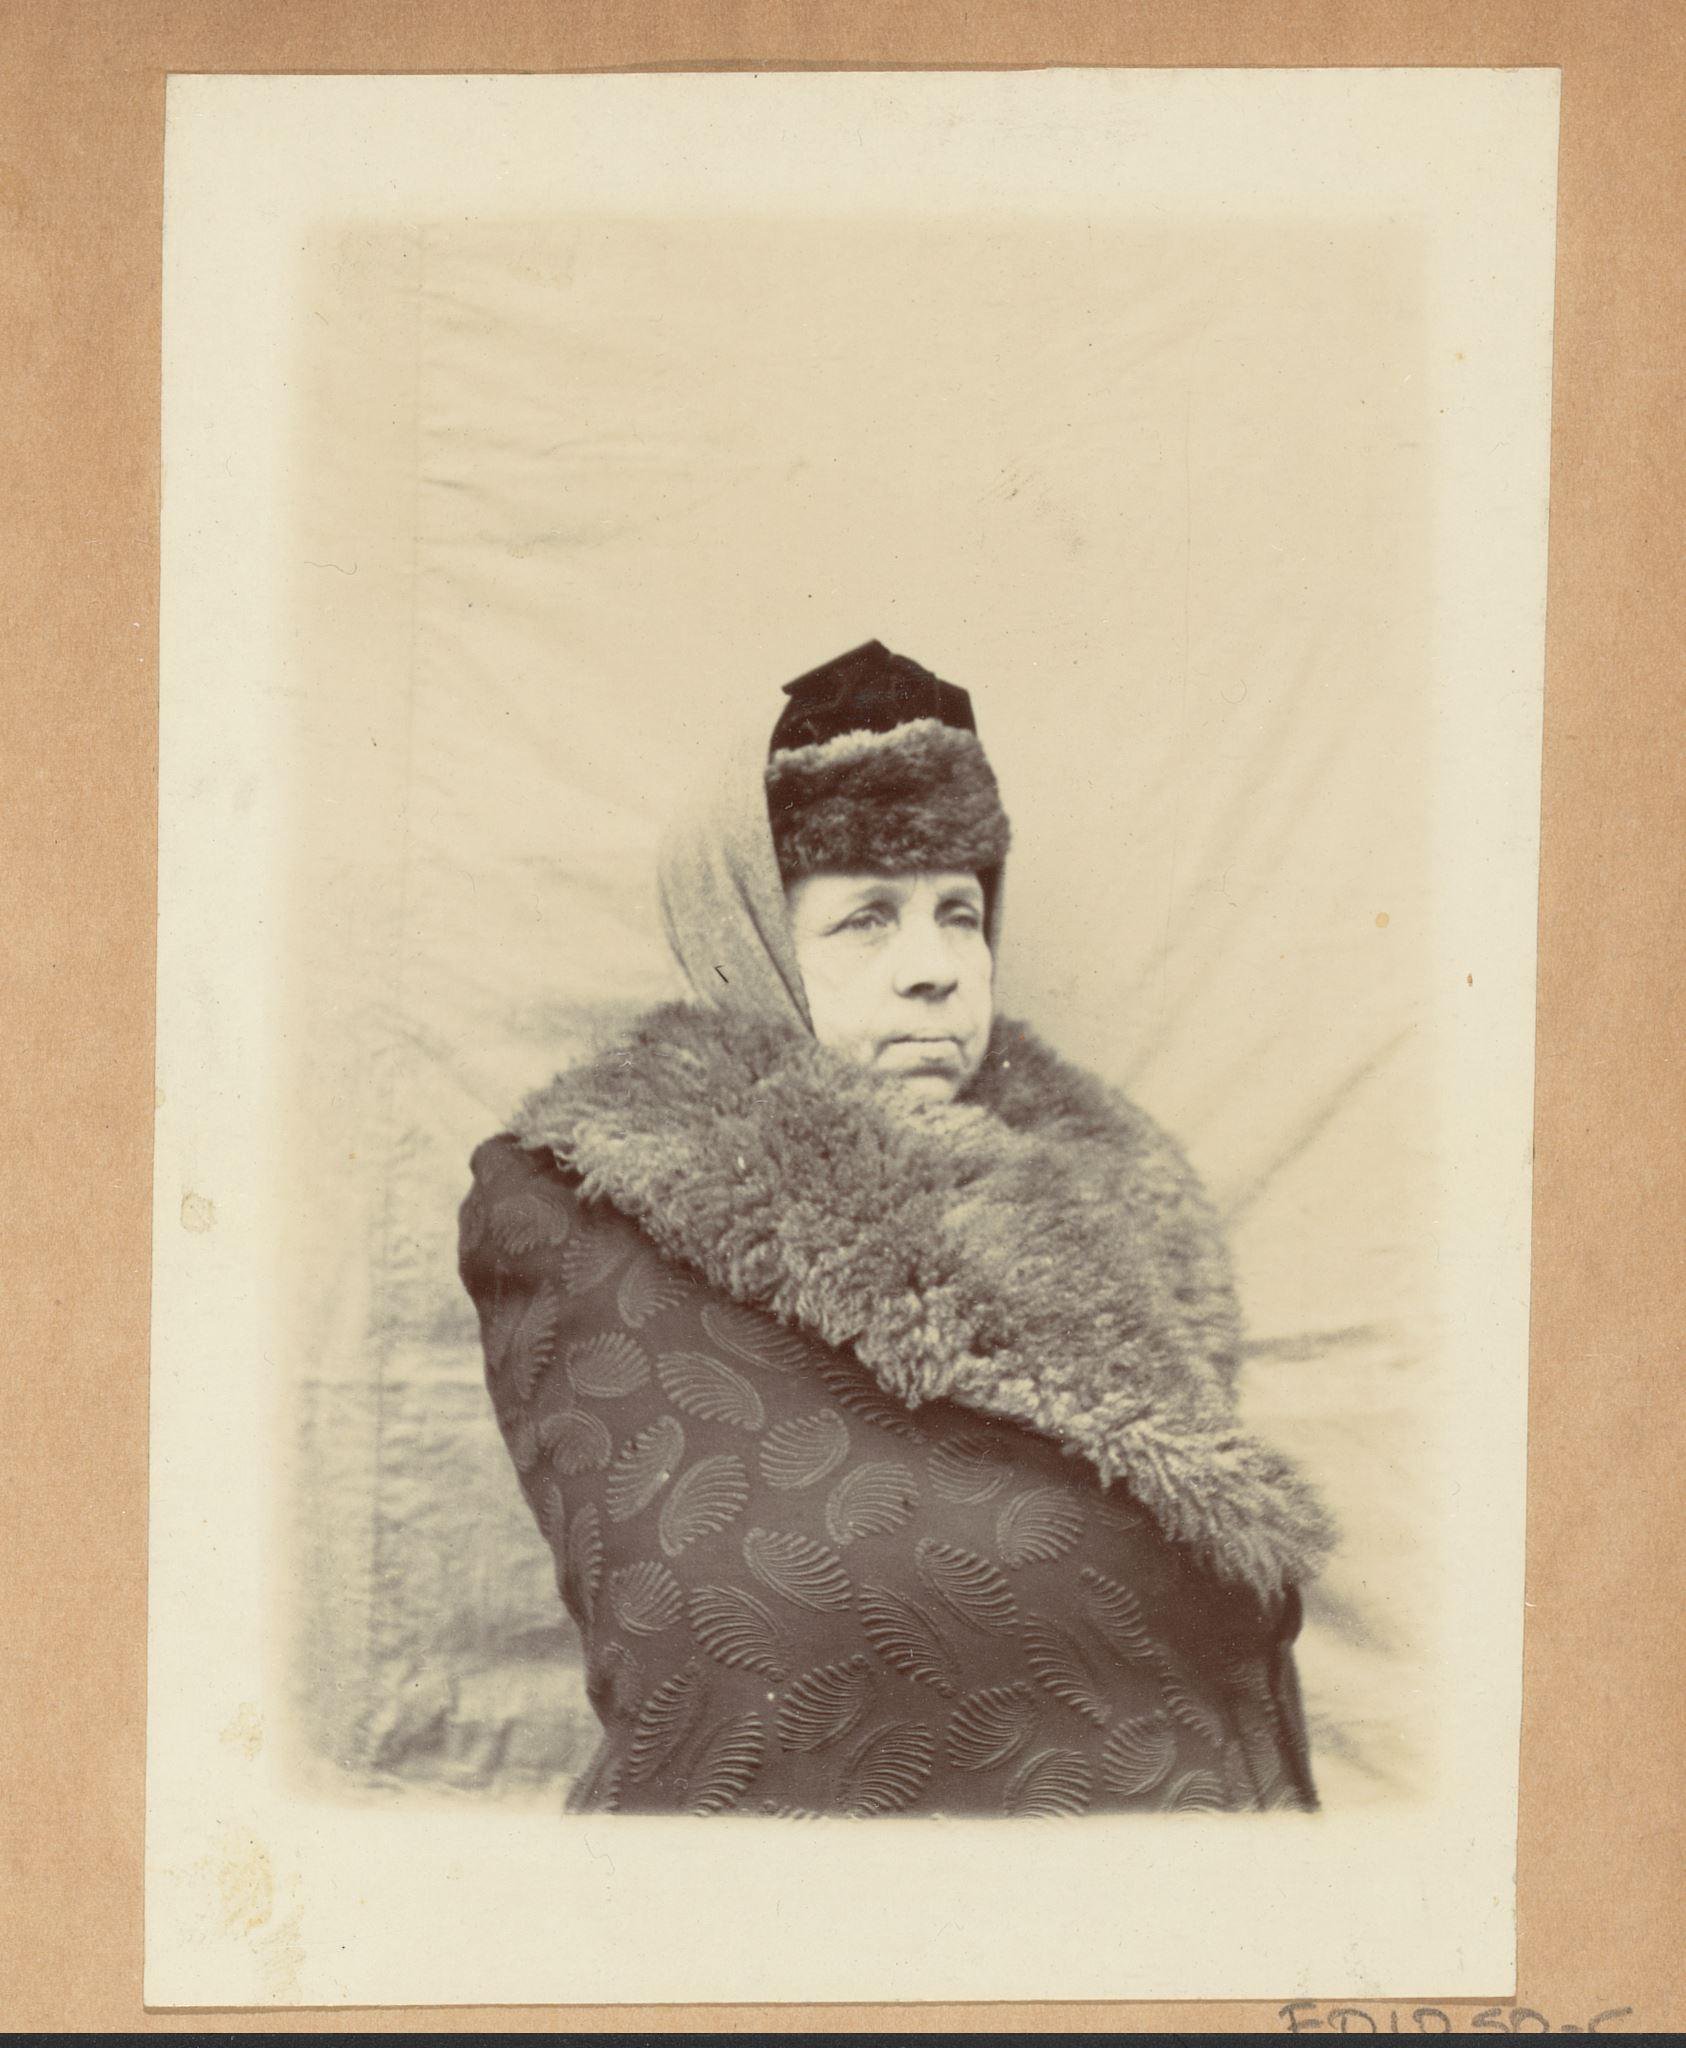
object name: photograph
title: Portret van mevrouw Cheetham-Winter met winterjas, muts en sjaal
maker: joseph cheetham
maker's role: engineer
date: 1903-1904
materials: photographic support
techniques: gelatin silver print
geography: russia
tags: adult woman, head-gear (with name), coat (+ fur used for clothes), head-gear: cap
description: Onderdeel van Fotoalbum van de Engelse familie Cheetham met opnames van hun verblijf in Rusland.